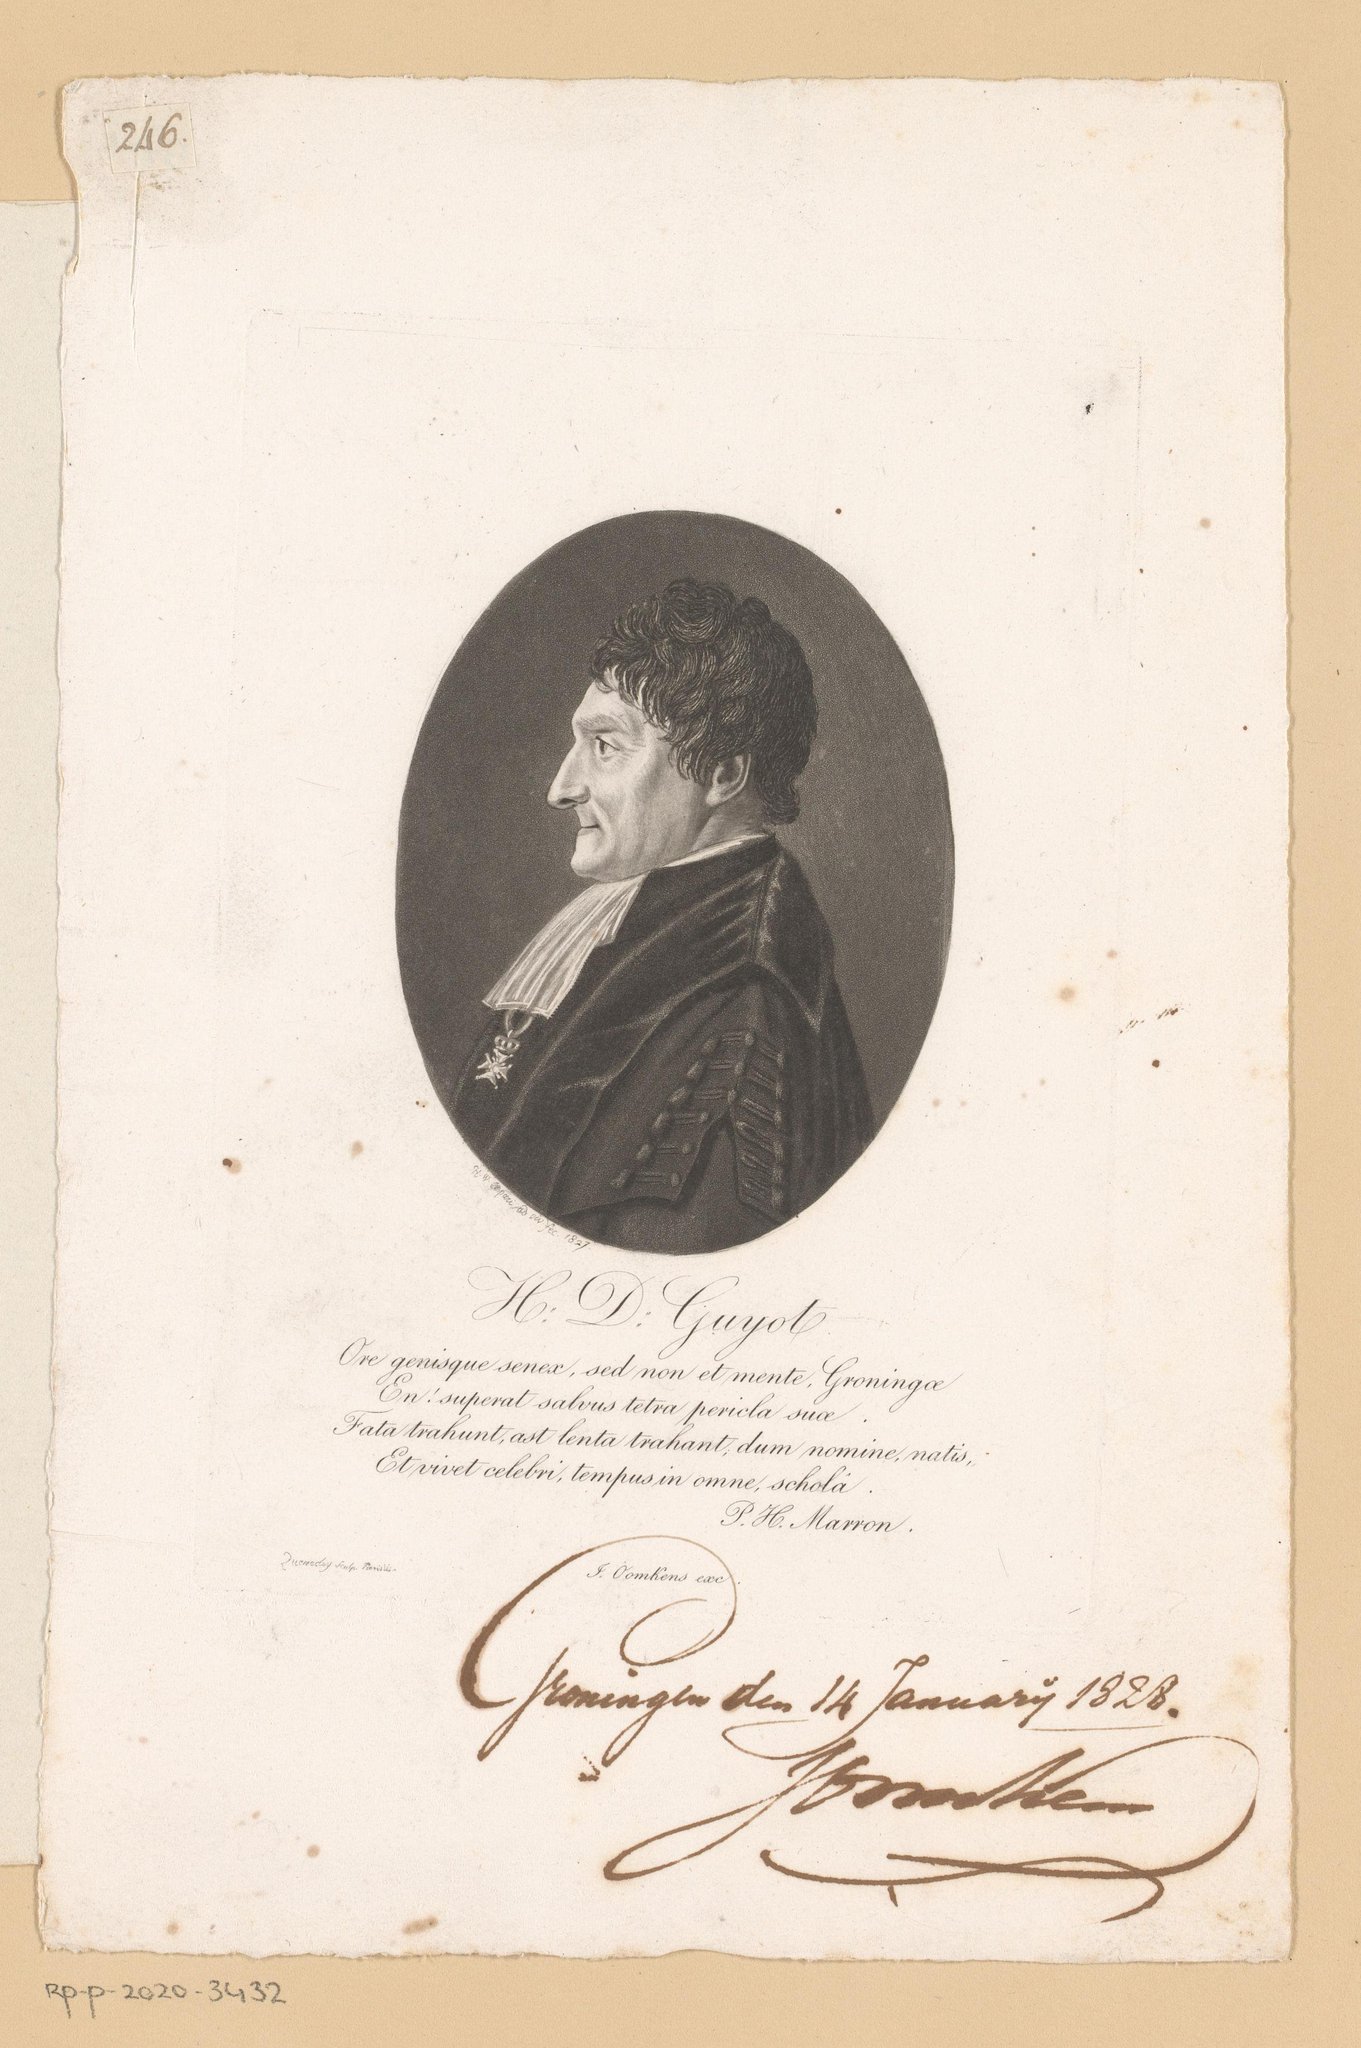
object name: physionotrace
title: H.D. Guyot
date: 1828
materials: paper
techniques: aquatint, etching, letterpress printing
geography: groningen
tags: france, silhouette-apparatus, 'physionotrace', historical persons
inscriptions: collector's mark: Lugt 2228, inscription: ‘Groningen den 14 Januarij 1828. J. Oomkens’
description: Physionotrace portret. Onder het portret een vierregelig vers in het Latijn door Paul Henri Marron. Bij het portret een gevouwen blad met een herdenkingsgedicht door Barthold Hendrik Lulofs. Zowel het tekstblad als het portret zijn gesigneerd en gedateerd (veertien januari 1828) door de uitgever, Jan Oomkens.